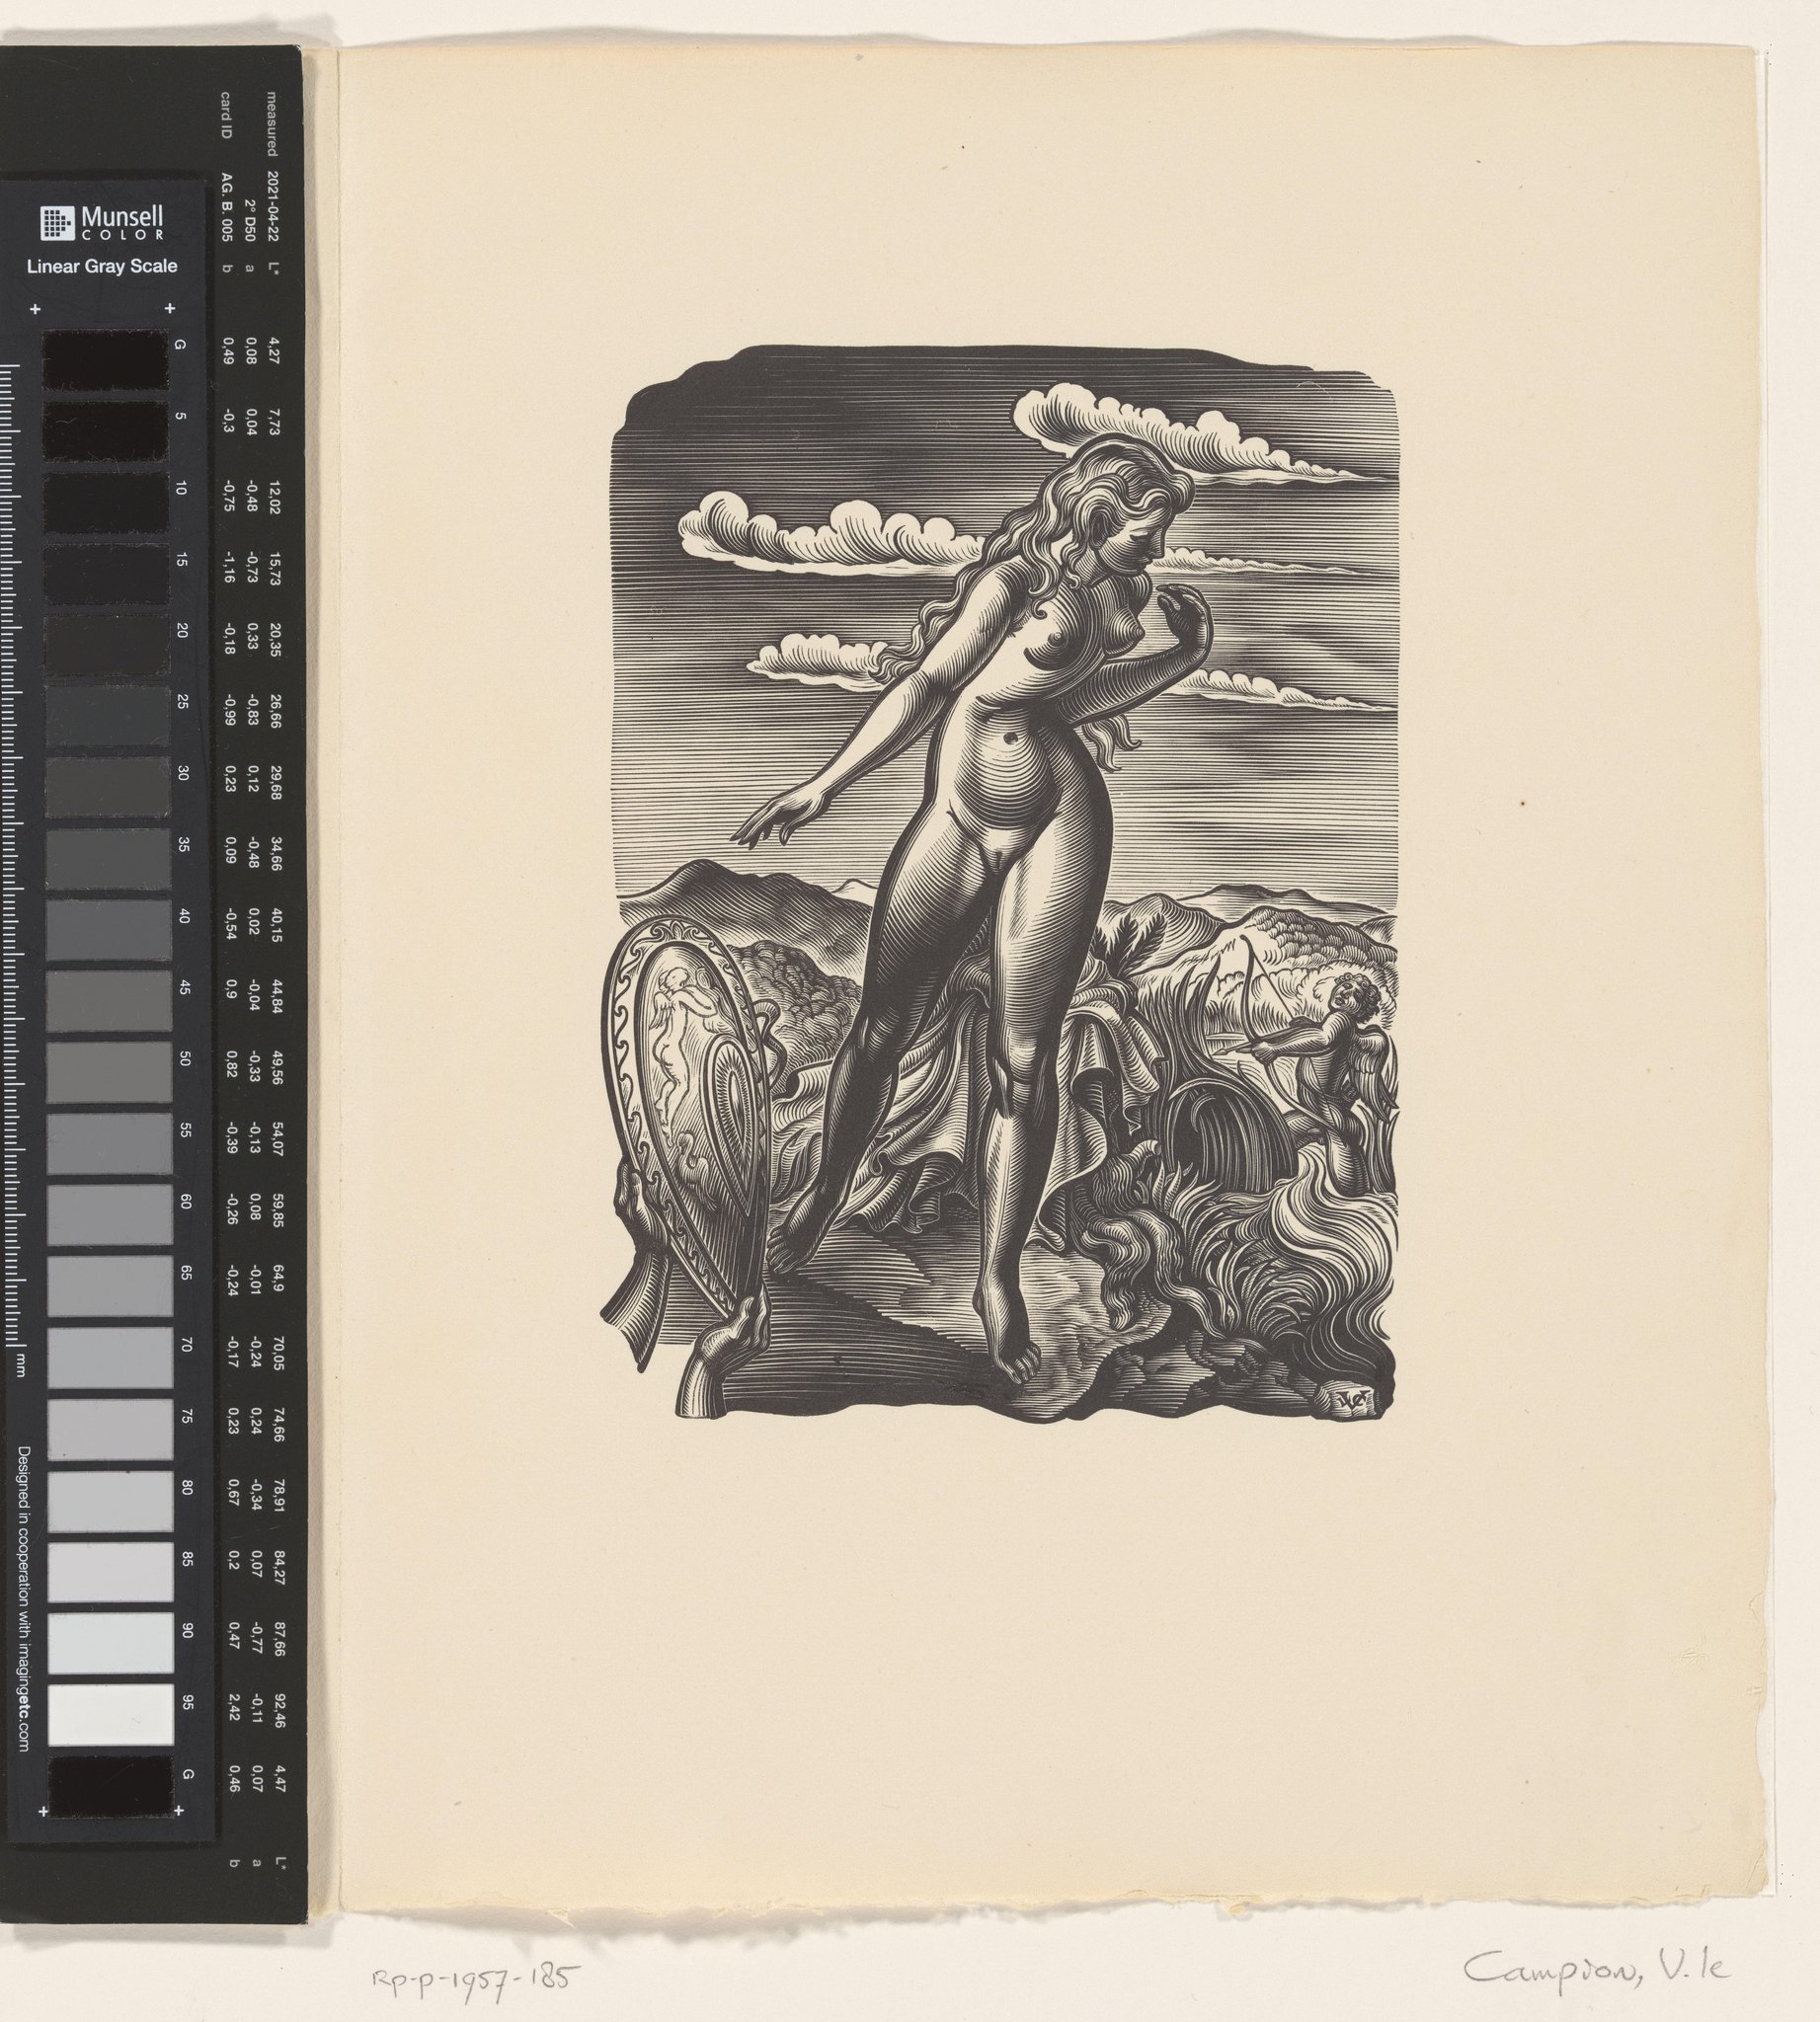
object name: print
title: Amor richt zijn pijl op een vrouw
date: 1952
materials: paper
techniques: letterpress printing, engraving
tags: cupid shooting a dart, human figure of ideal proportions, e.g. academic nude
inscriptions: collector's mark: Lugt 2228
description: Herdruk van een prent die als boekillustratie gebruikt is voor: Ovidius. L'art d'aimer. Parijs: Les Bibliophiles de Montmartre, 1950.